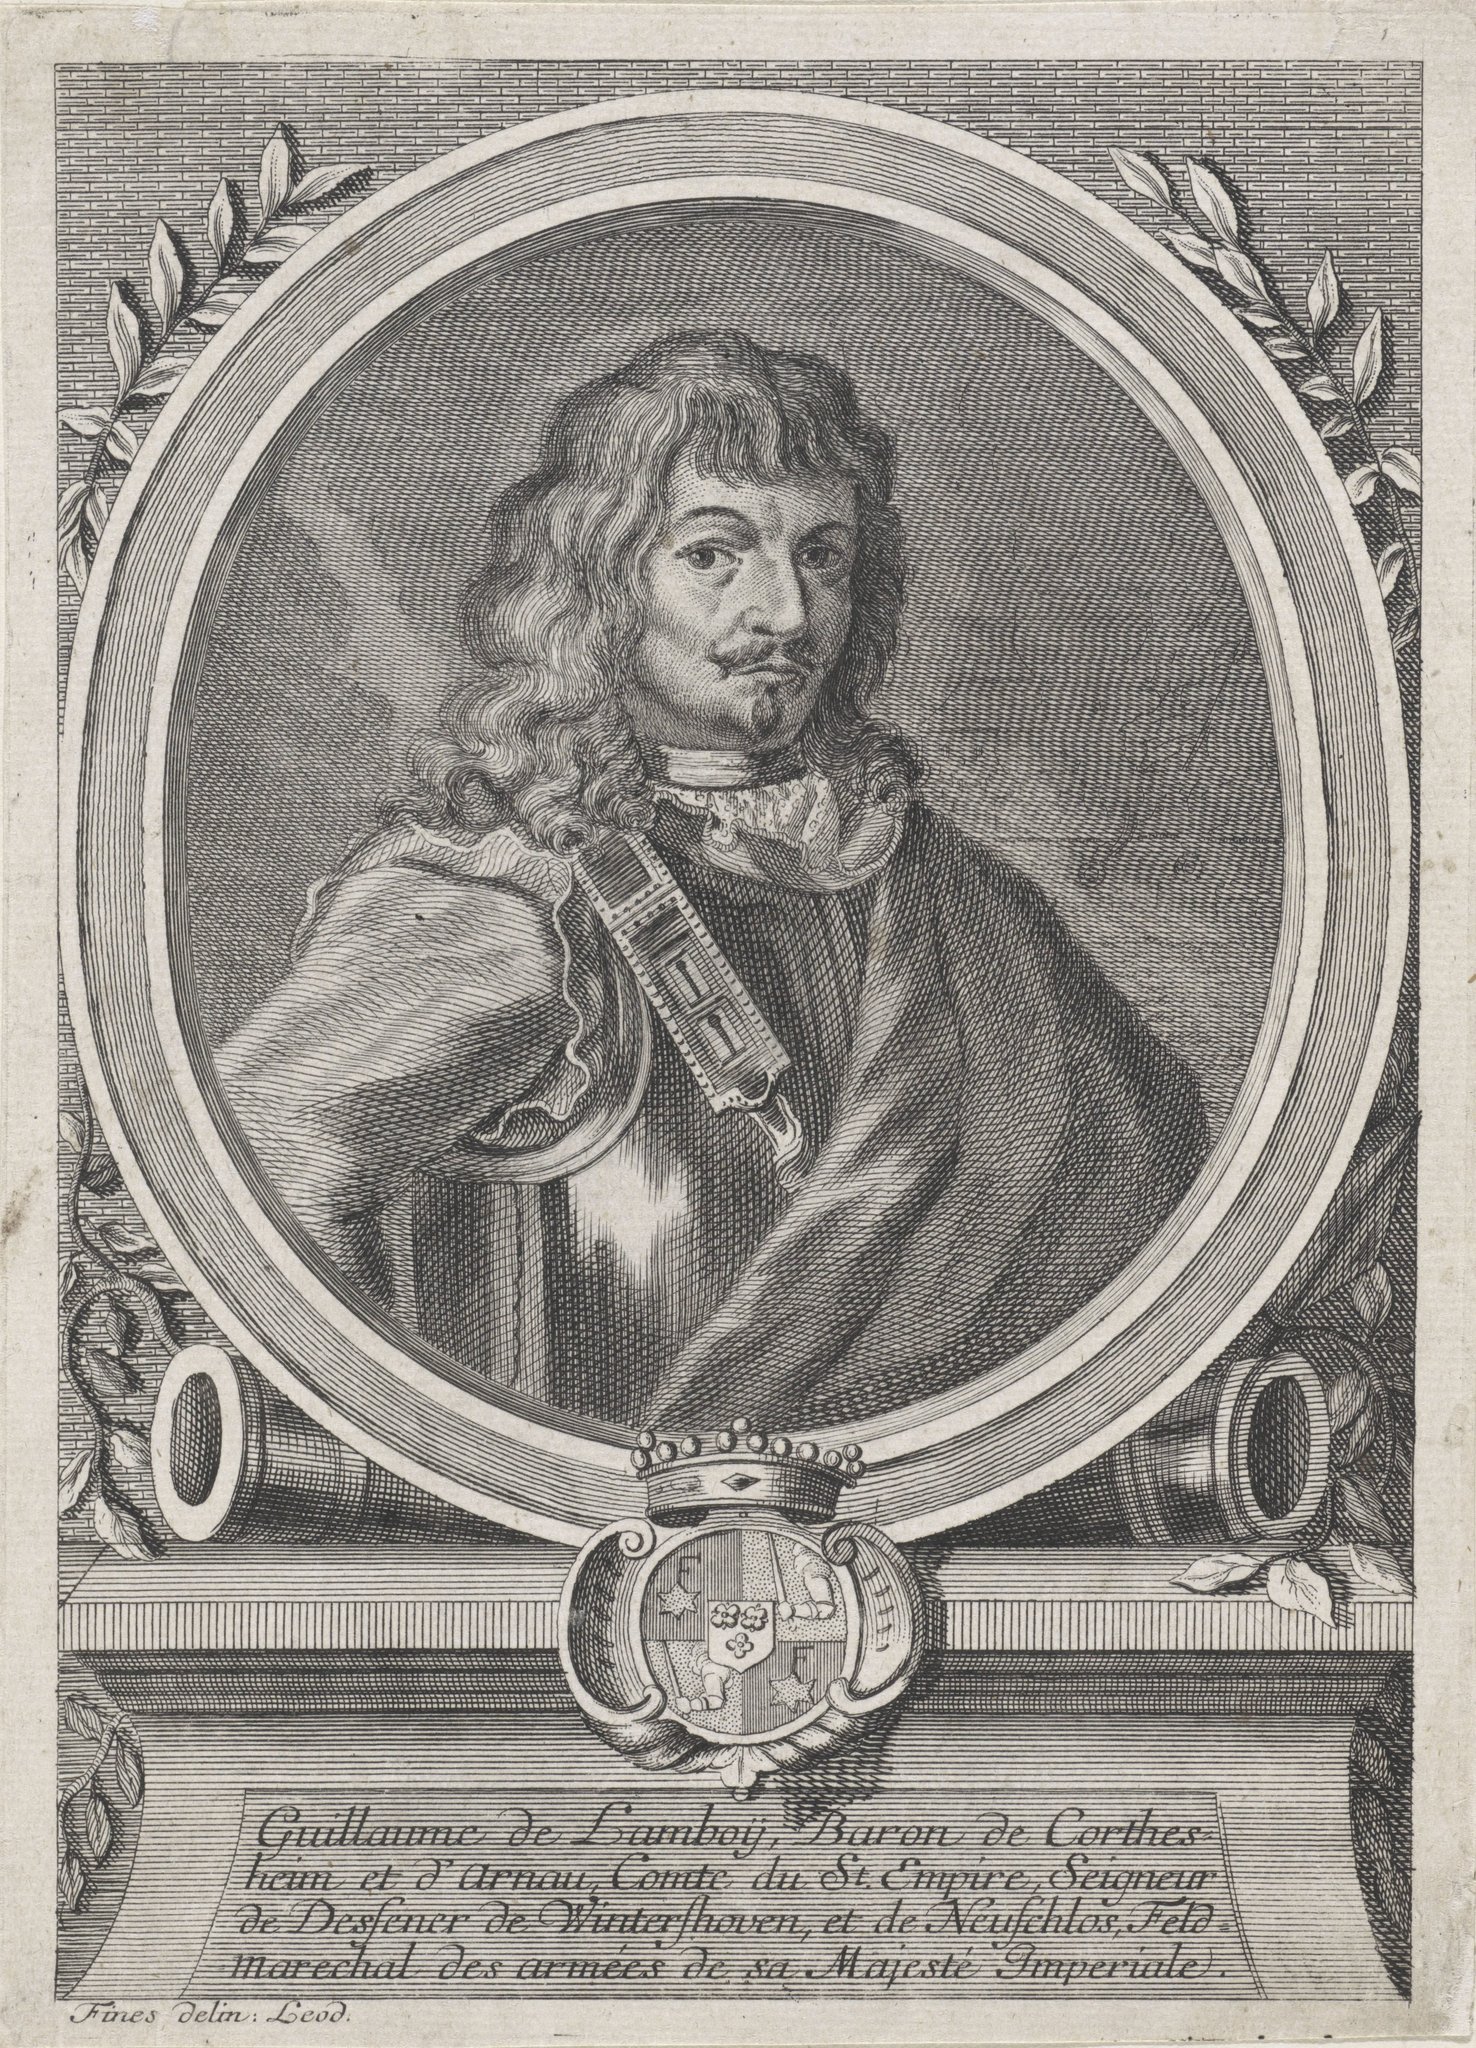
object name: print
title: Portret van Guillaume de Lamboy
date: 1649-1659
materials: paper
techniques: engraving, etching, roulette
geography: liège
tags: historical persons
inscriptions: collector's mark: Lugt 2228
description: Buste van de generaal Guillaume de Lamboy in een ovale omlijsting. De lijst is versierd met lauriertakken en twee kanonnen. Onderaan een wapen en een vierregelig onderschrift over de geportretteerde in het Frans.